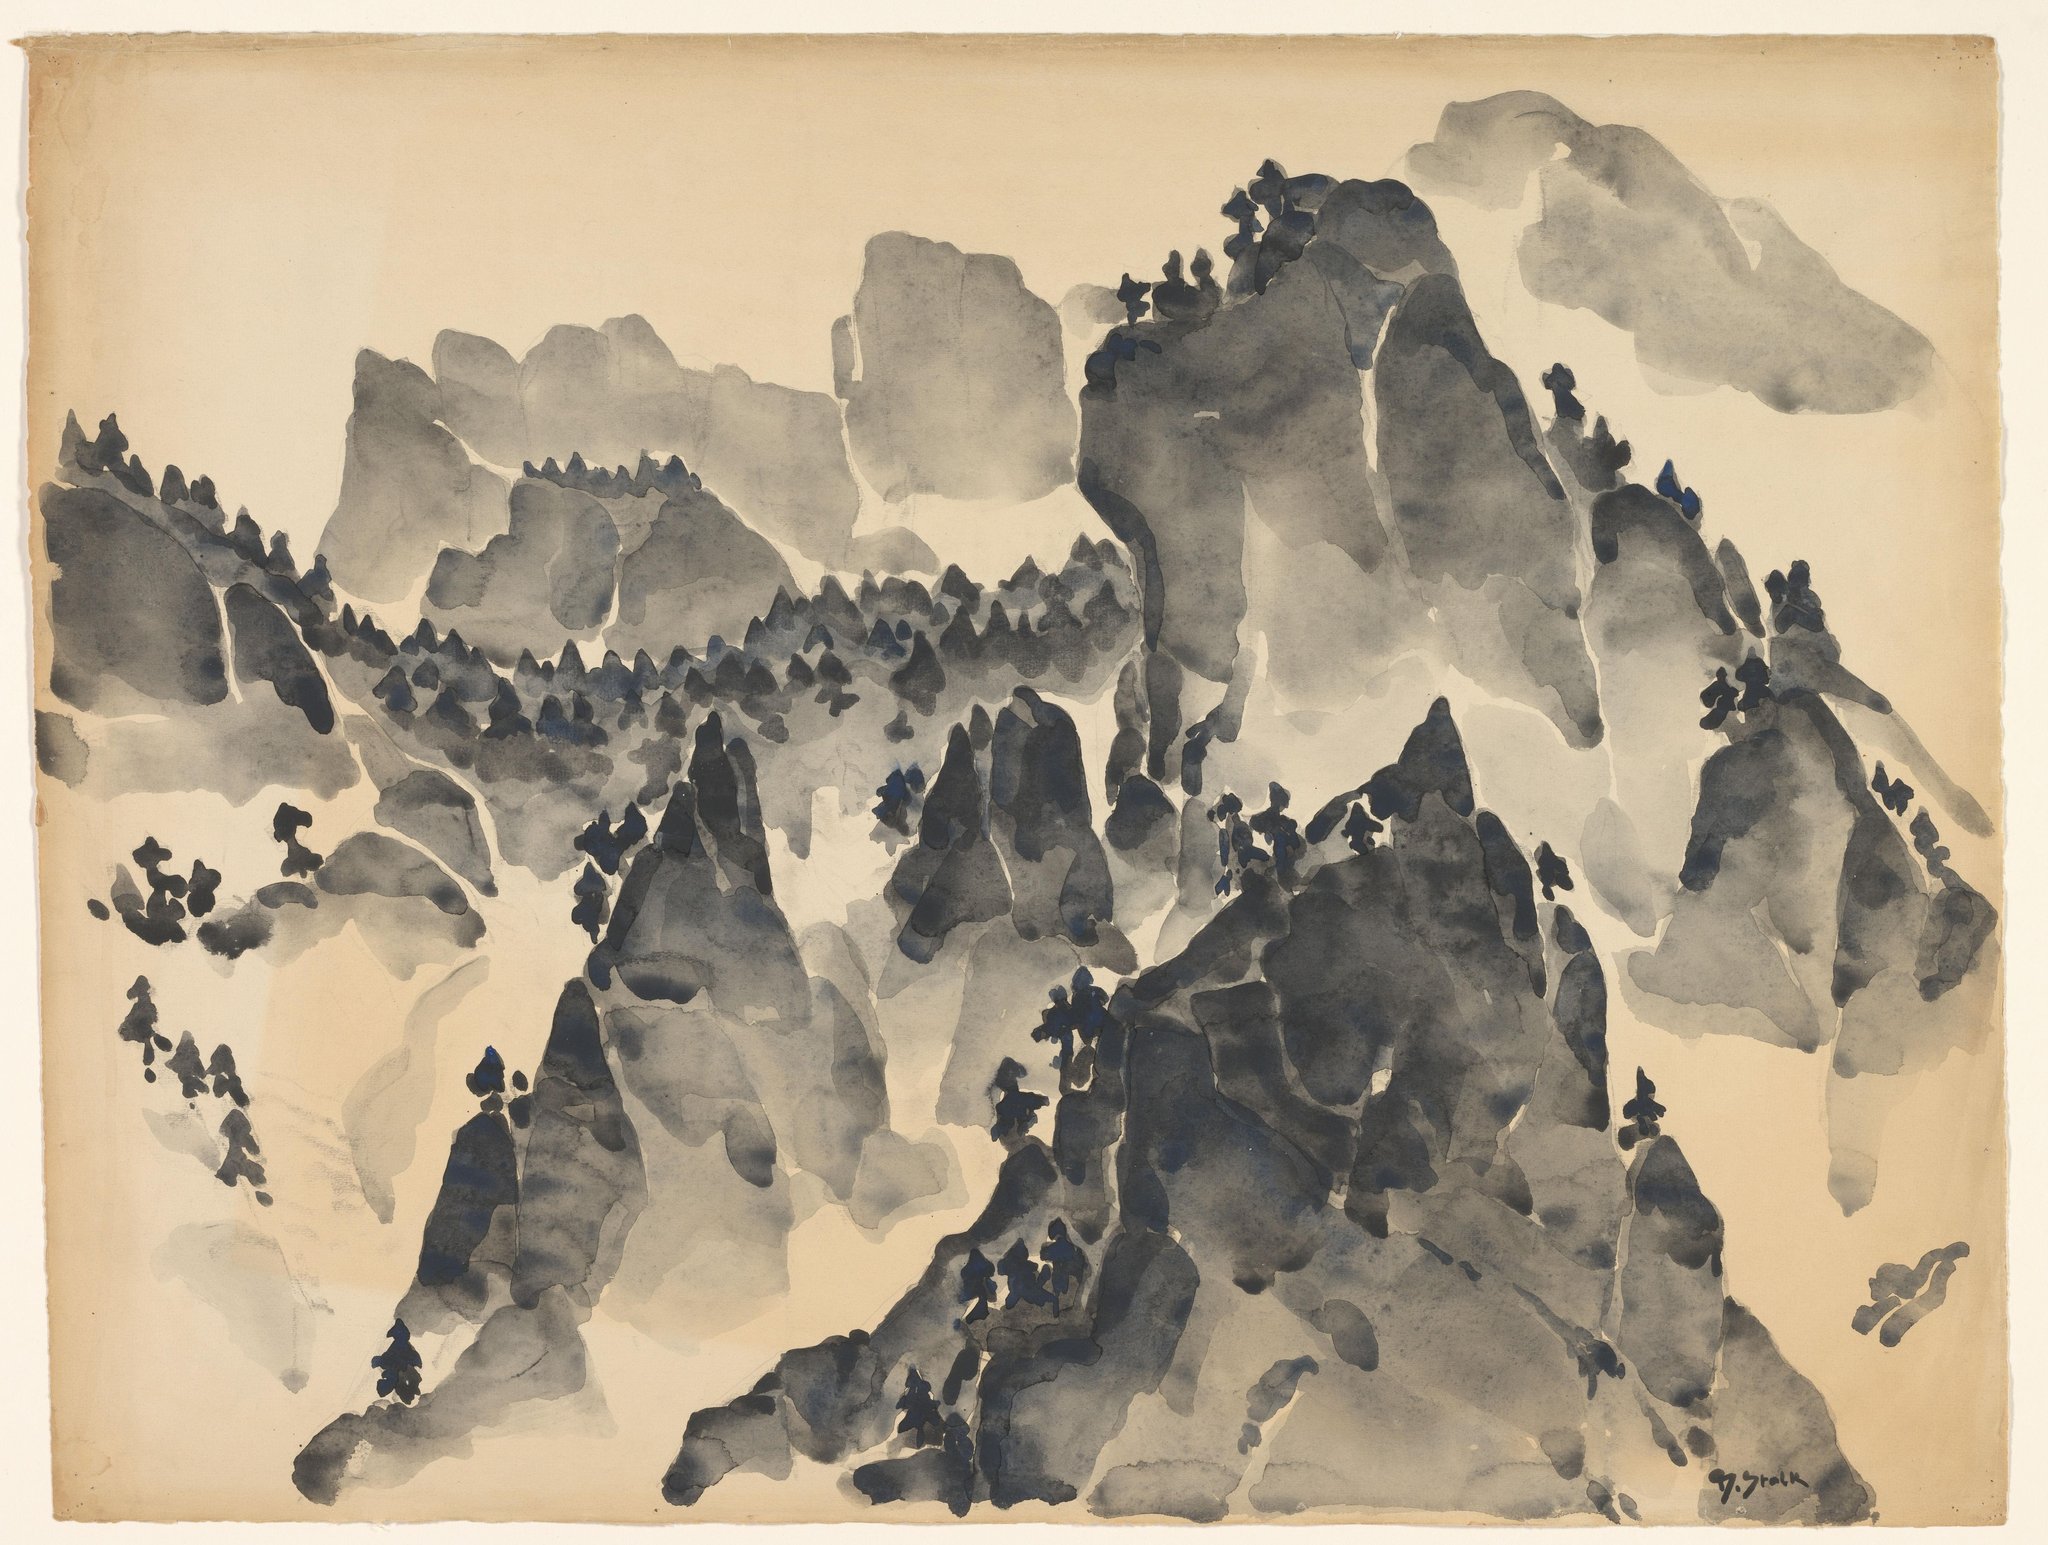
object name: drawing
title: Berglandschap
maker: reijer stolk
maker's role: draughtsman, print maker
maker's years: 1896-1945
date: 1906-1945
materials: paper, pencil, watercolor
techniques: brush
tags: trees, mountains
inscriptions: collector's mark: Lugt 2228